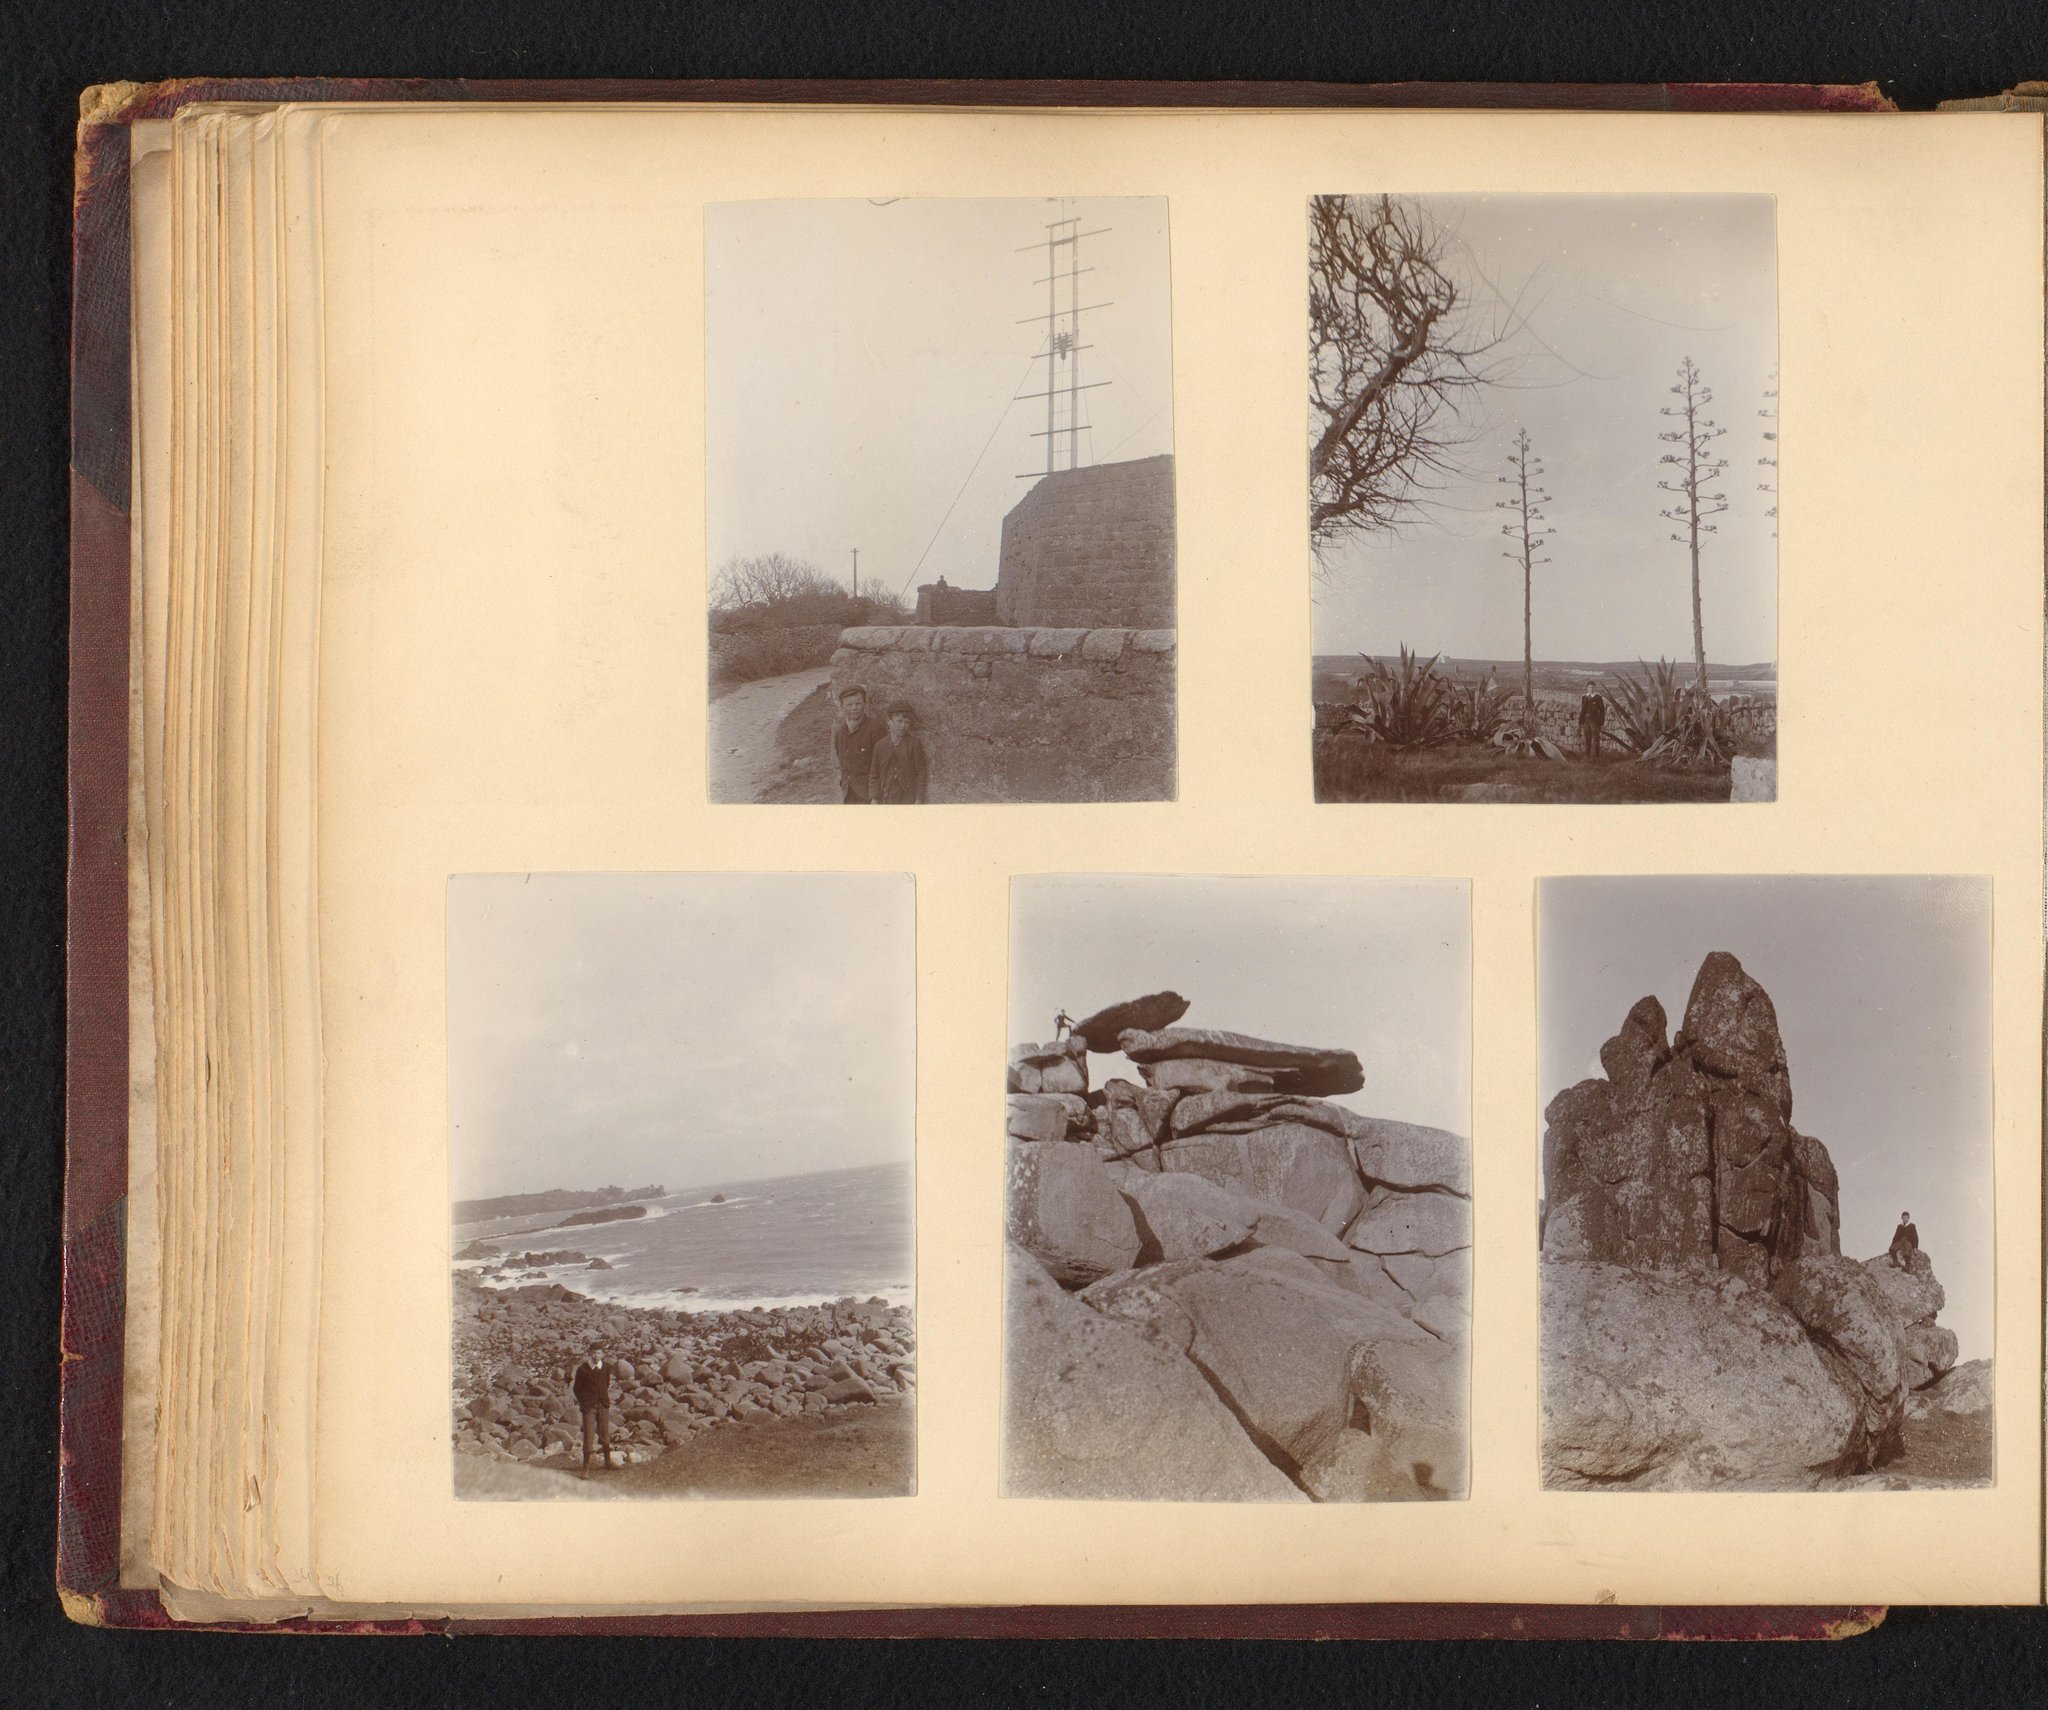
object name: album leaf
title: Jongens in verschillende landschappen, onder meer op rosten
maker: Anonymous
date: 1890-1898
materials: photographic support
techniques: collodion silver print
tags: boy (child between toddler and youth), youth, adolescent, rock-formations, coast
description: Deze pagina maakt deel uit van een album.